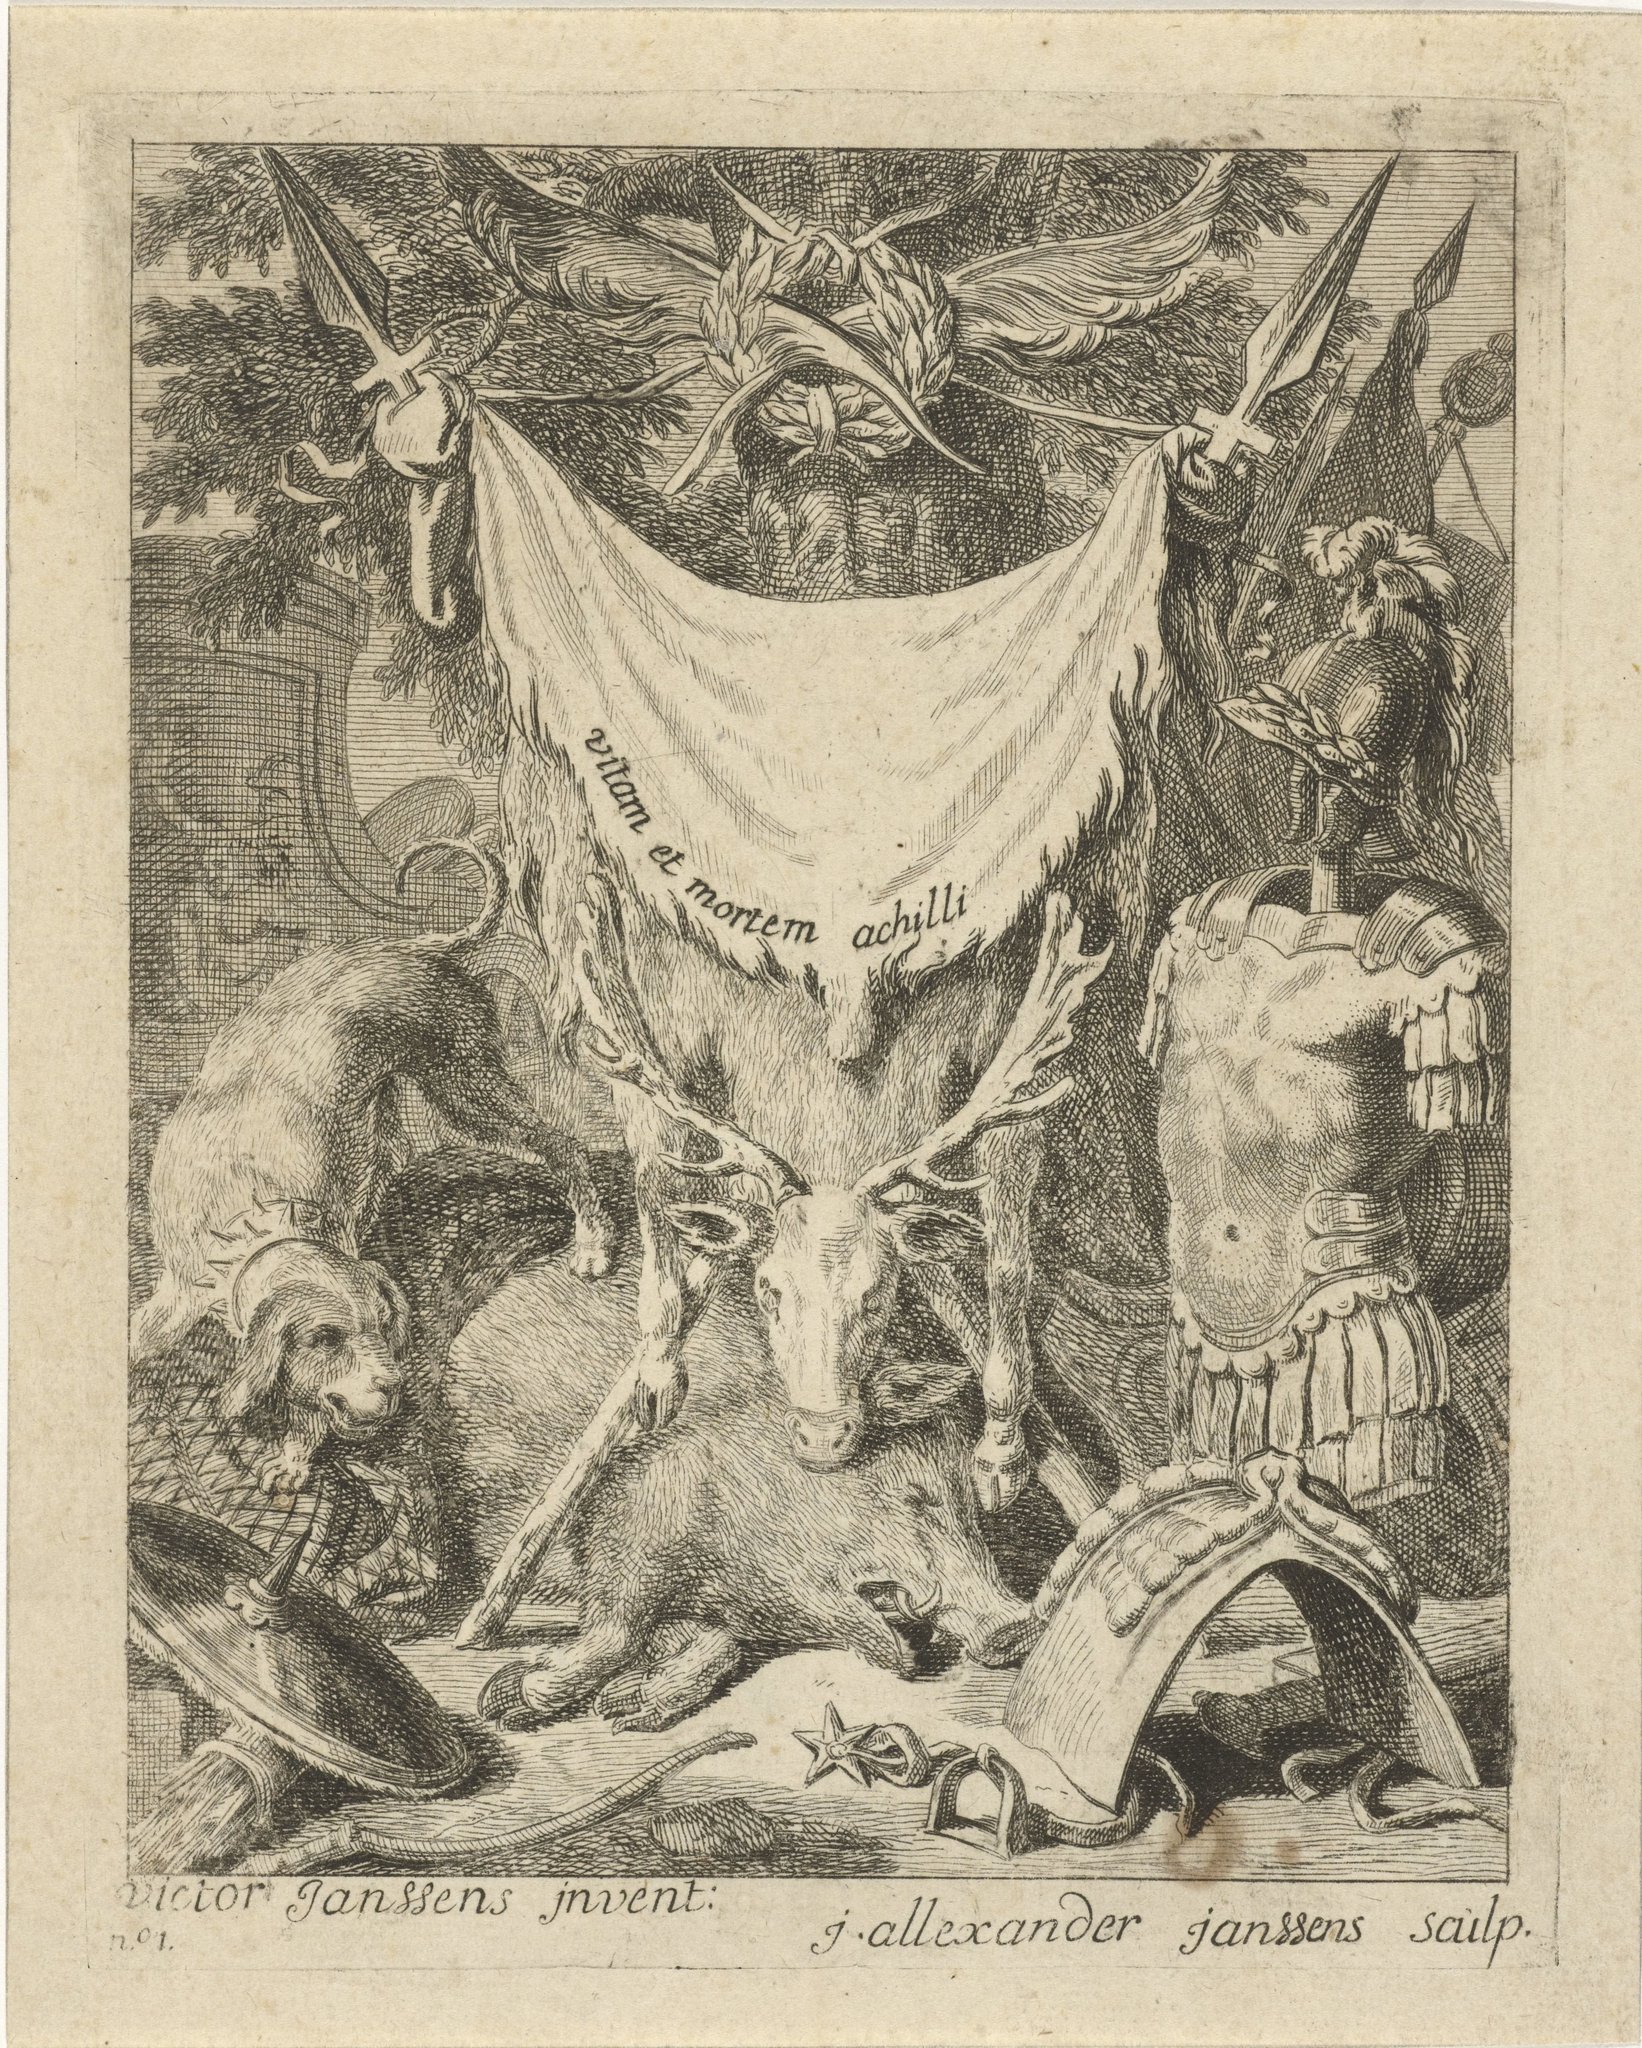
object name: titelprent, frontispice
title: Titelprent voor een serie met scènes uit het leven van Achilles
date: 1700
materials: paper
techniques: engraving, etching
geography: southern netherlands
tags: (story of) achilles - attributes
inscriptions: collector's mark: Lugt 2228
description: Op de voorgrond het wapenschild, zadel en harnas van Achilles, met hond, everzwijn en hert. Een doek met de serietitel hangt tussen twee speren. Daarboven, aan een boom, hangt een krans met palmtakken. Linksonder: N.1. Eerste prent uit een serie van veertien met scènes uit het leven van Achilles.